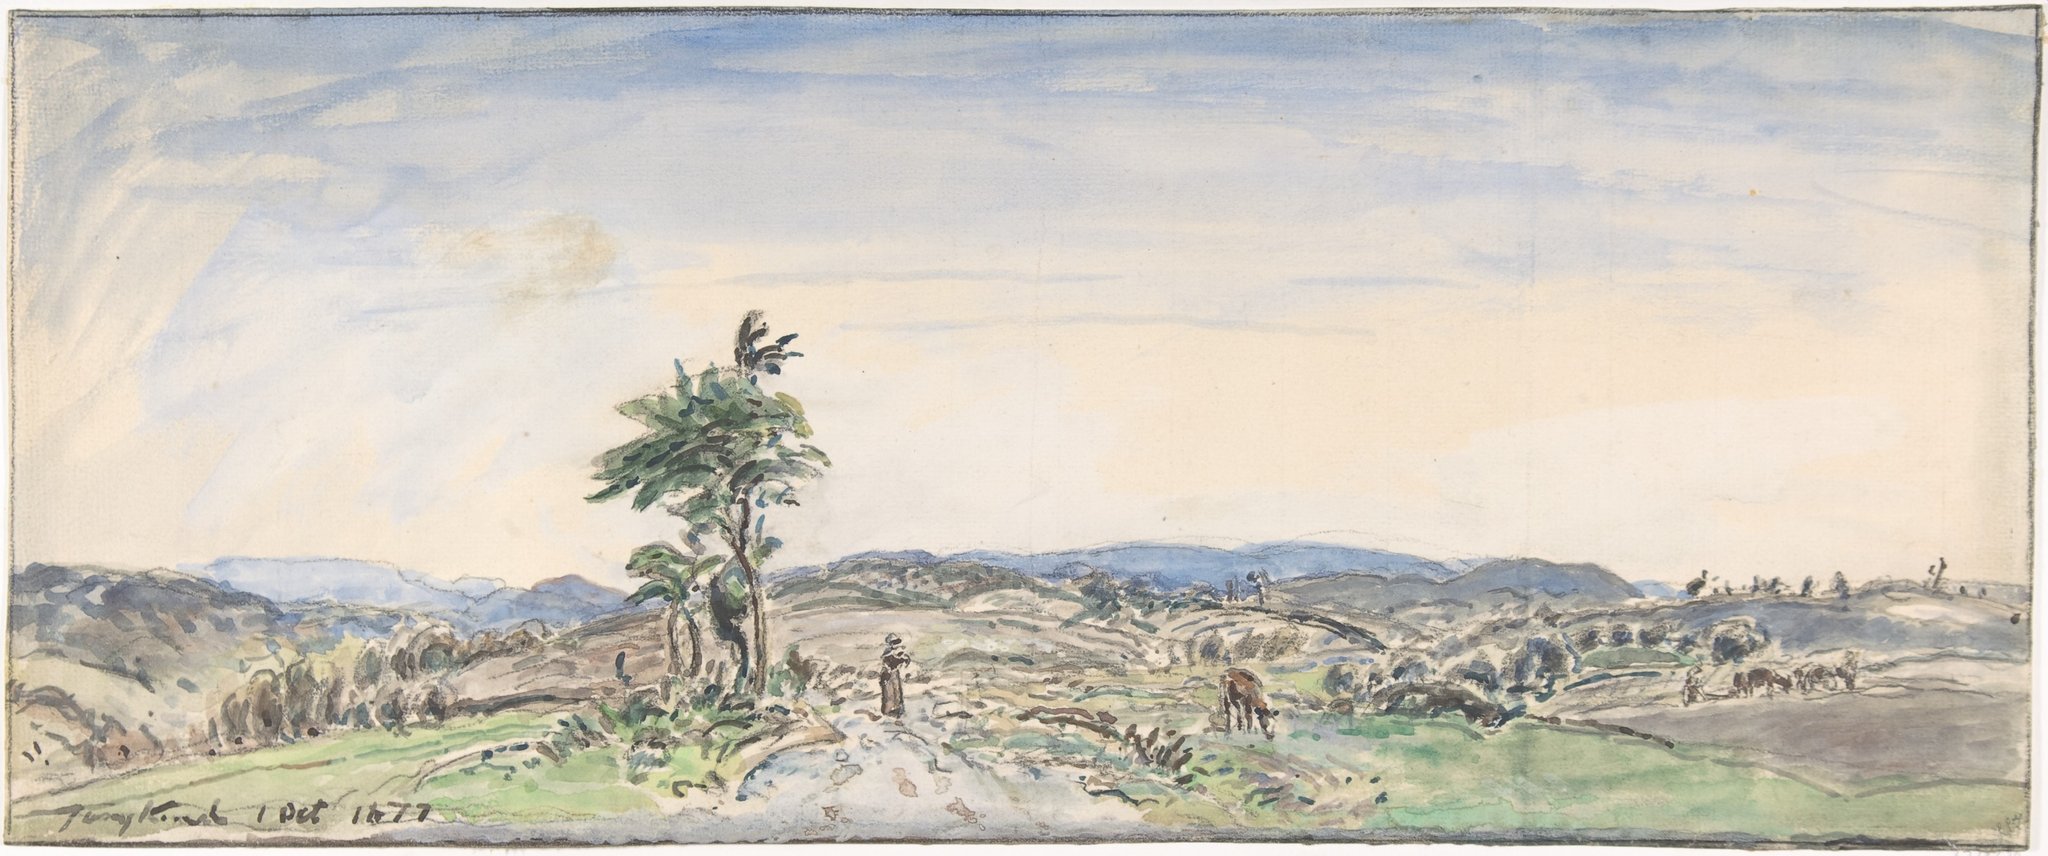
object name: drawing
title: Landscape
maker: johan barthold jongkind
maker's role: artist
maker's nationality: dutch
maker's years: 1819-1891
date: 1877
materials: chalk, watercolor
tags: landscapes,trees